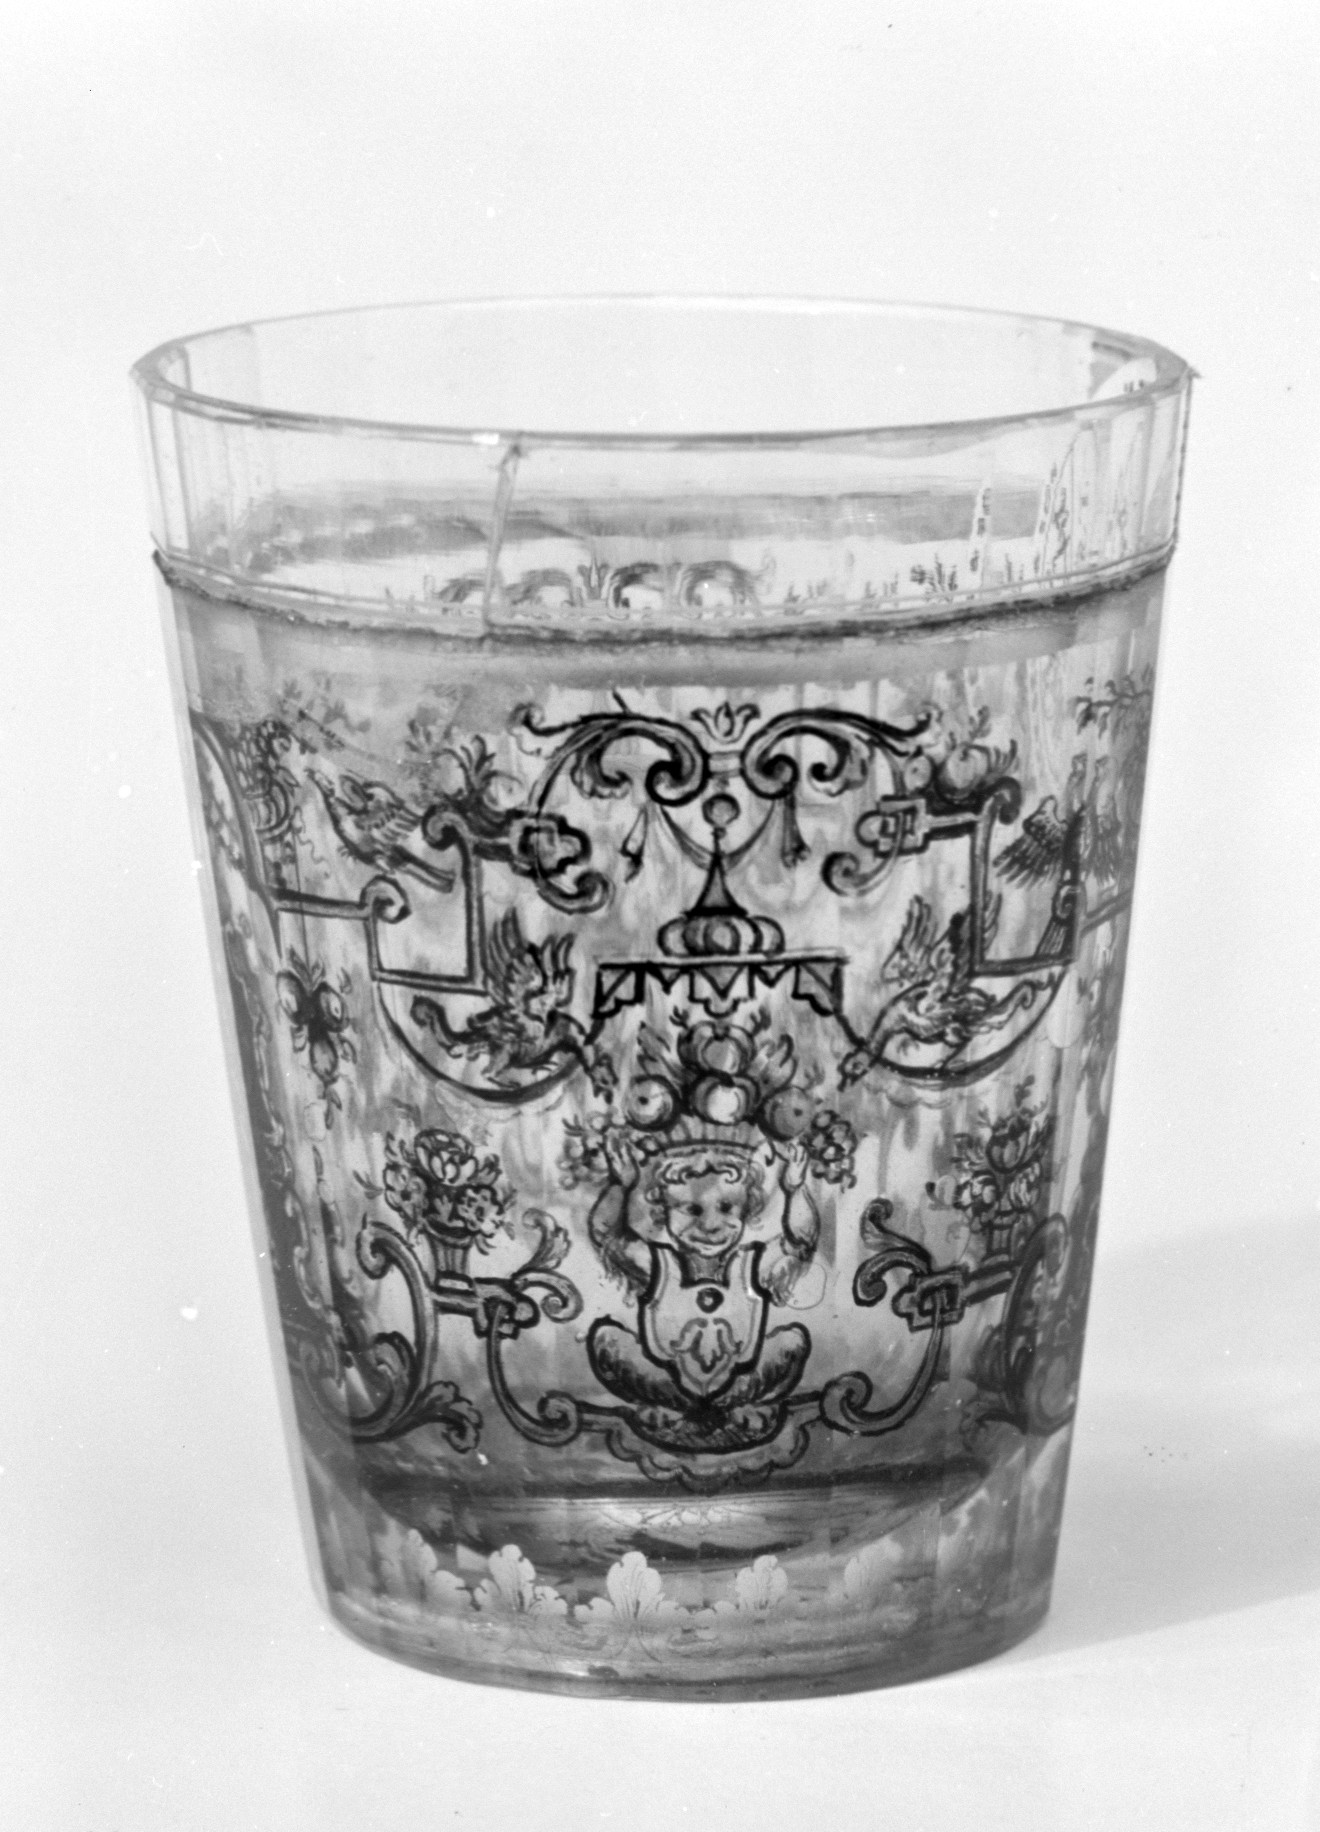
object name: beaker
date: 1730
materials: glass